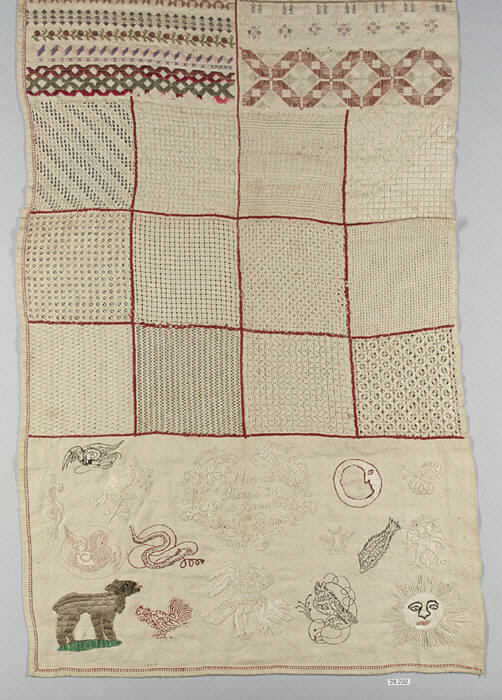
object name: sampler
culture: mexican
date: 1887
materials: cotton, linen, silk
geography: mexico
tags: animals,fish,butterflies,sun